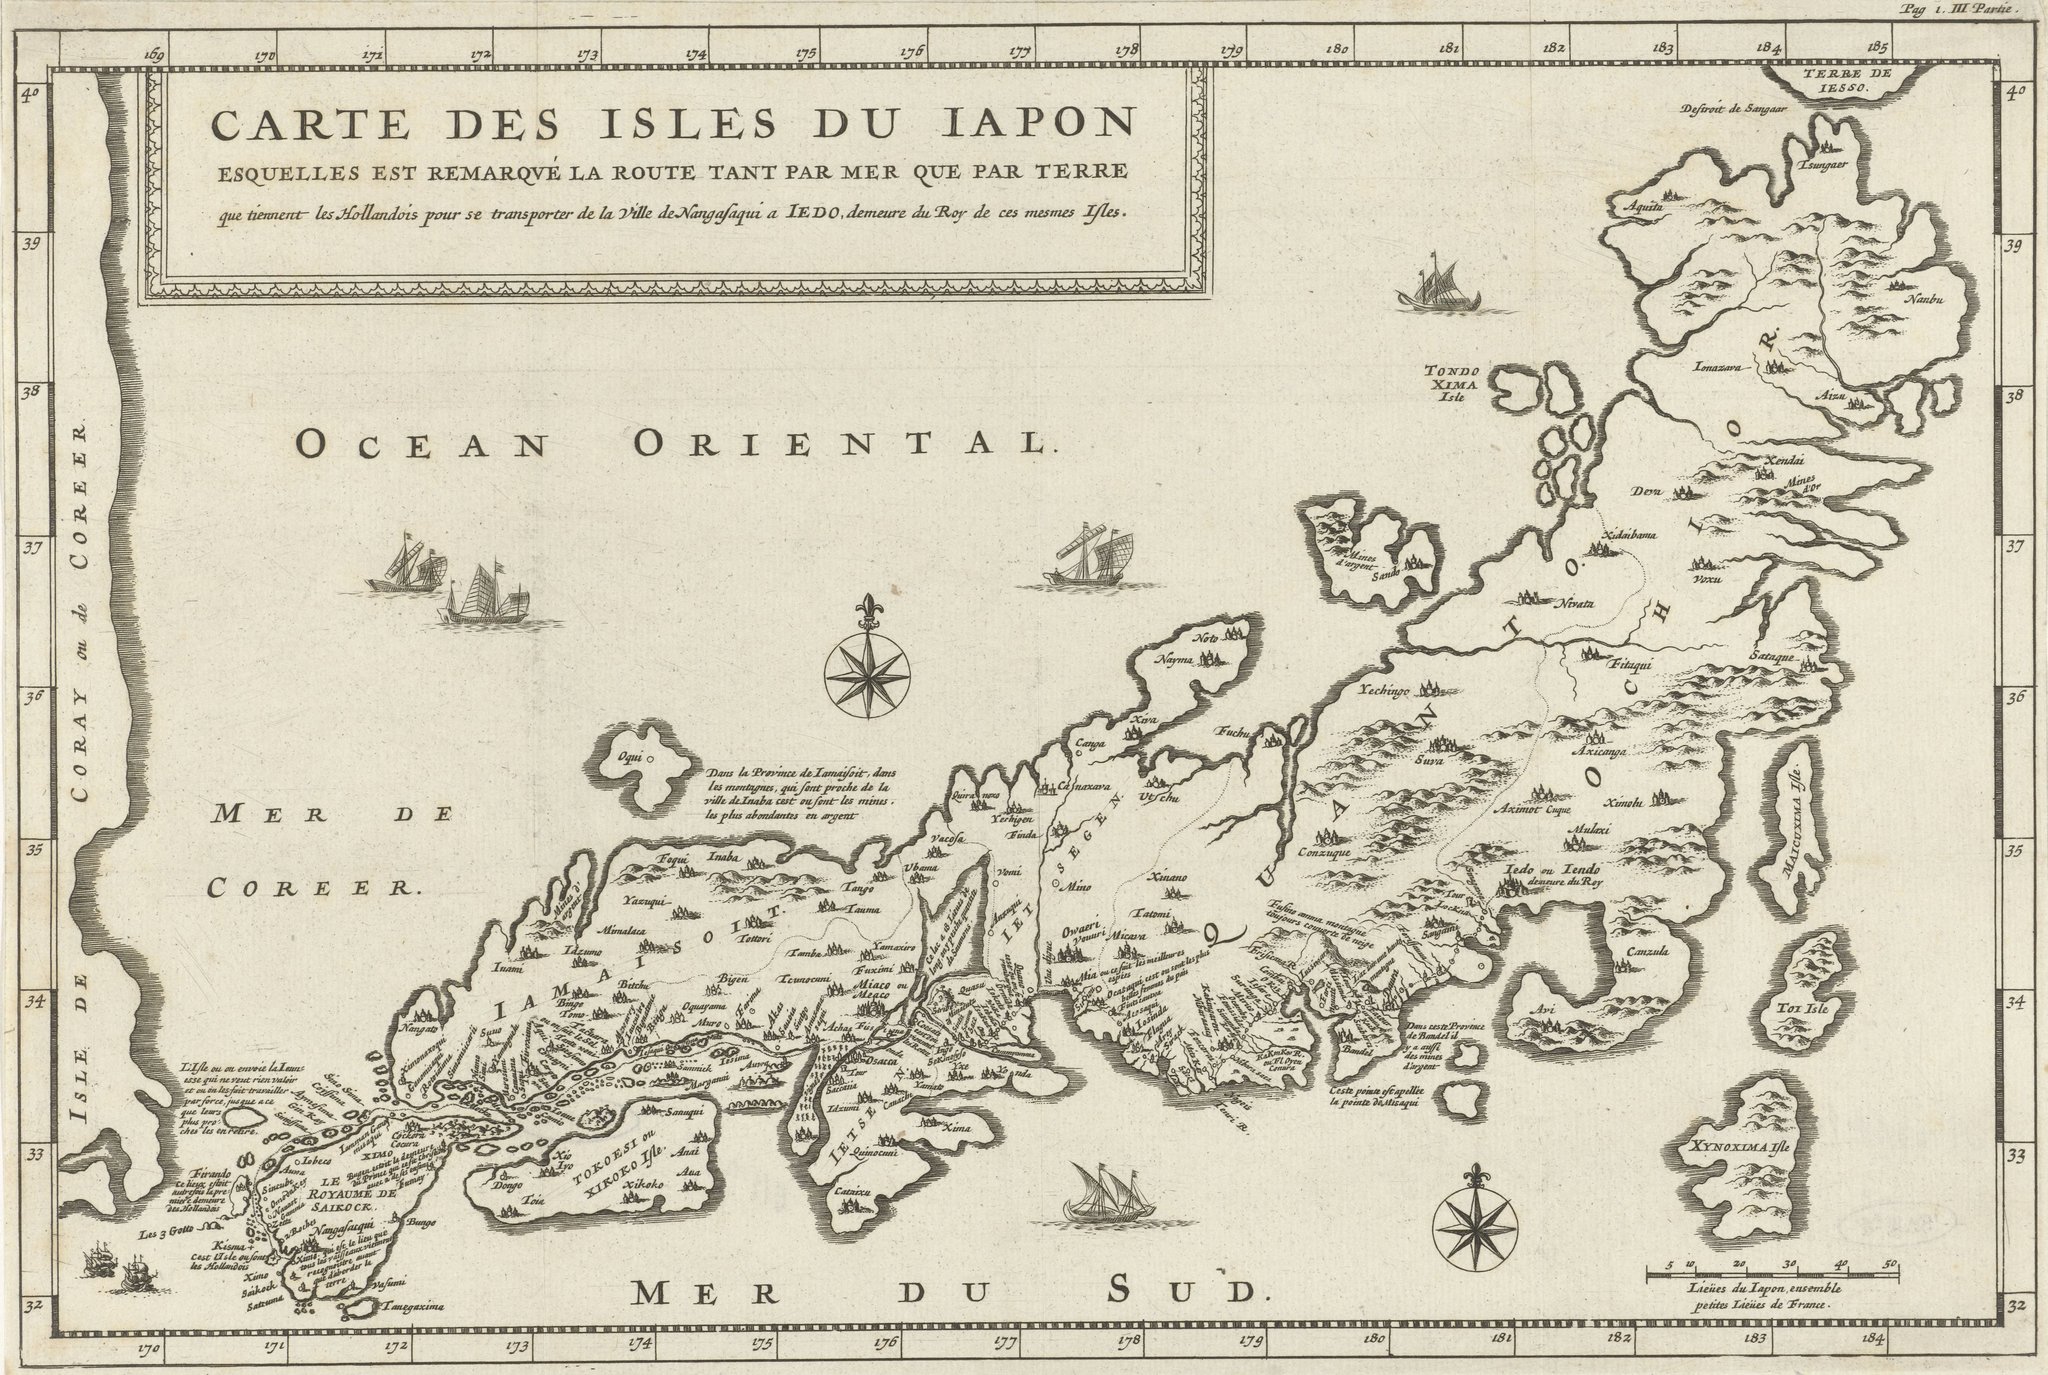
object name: print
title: Landkaart van Japan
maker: jan luyken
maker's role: draughtsman, print maker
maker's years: 1649-1712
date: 1681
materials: paper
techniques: etching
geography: amsterdam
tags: maps of separate countries or regions, japan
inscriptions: collector's mark: Lugt 2228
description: Illustratie vervaardigd voor deel III van: Tavernier, Jean Baptiste. Les six voyages de Jean Bapt. Tavernier (...) en Turquie, en Perse et aux Indes. Brussel: Eugène Henry Fricx, 1679. Tweede uitgave te Parijs, 1679-1681. Deel I en II verschenen in 1679. Deel III verscheen in 1681.